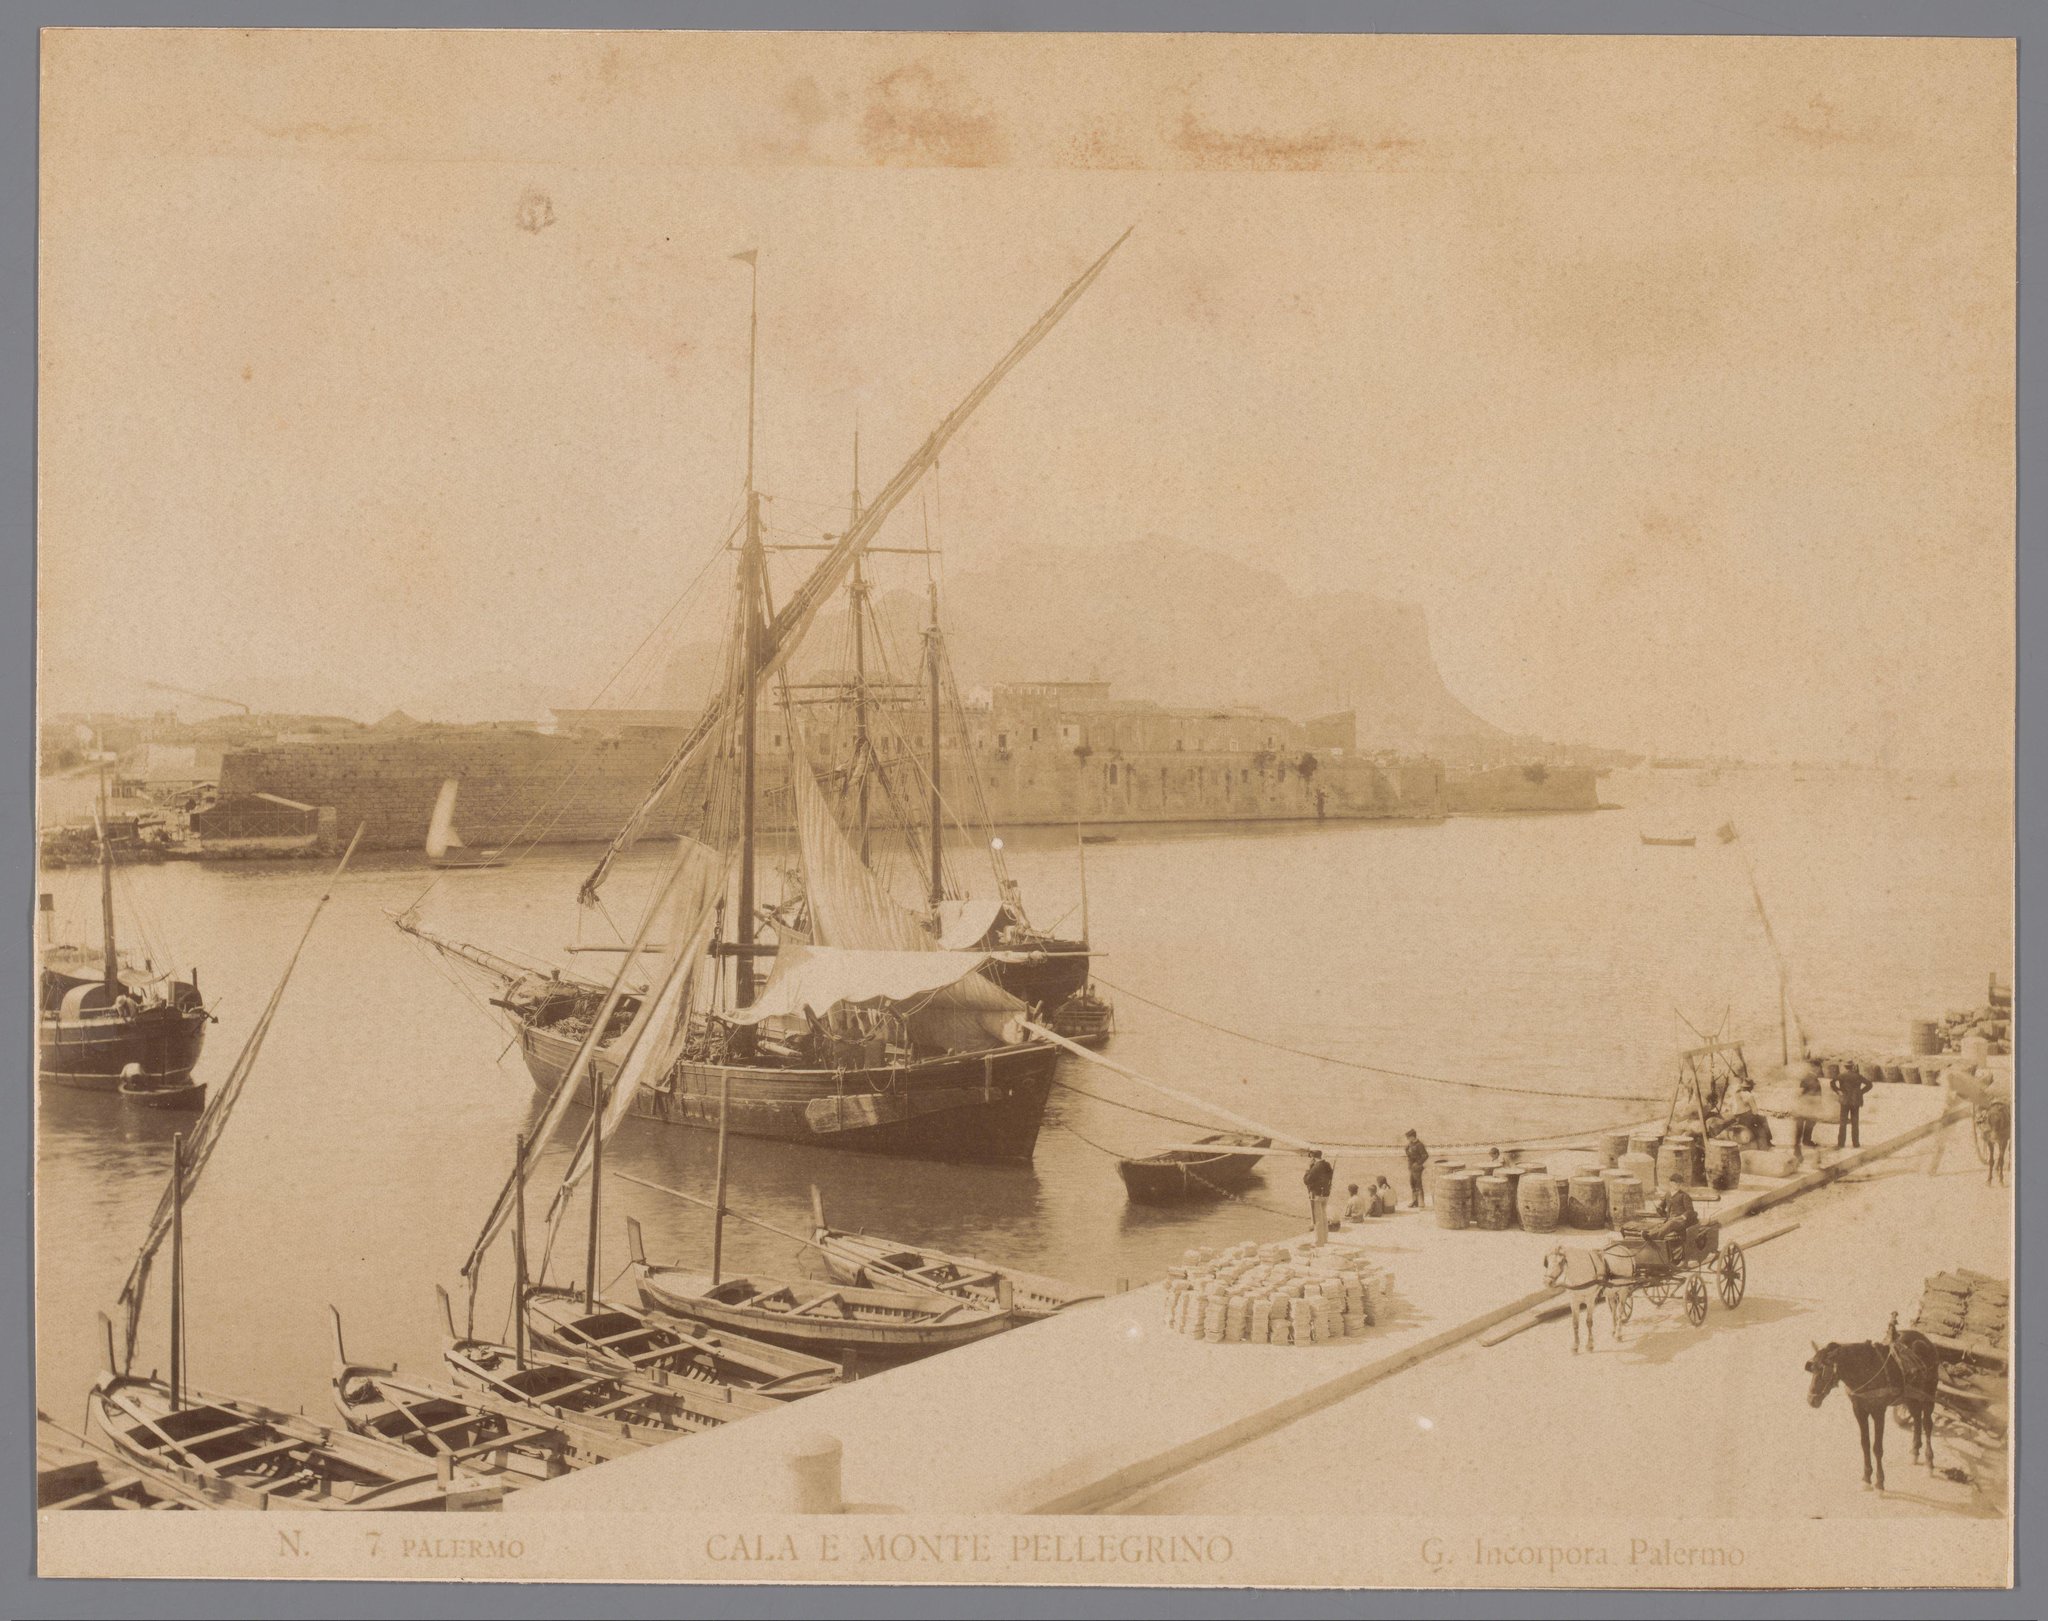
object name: photograph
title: Cala e Monte Pellegrino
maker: giuseppe incorpora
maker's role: fotograaf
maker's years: 1834-1914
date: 1856-1914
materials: paper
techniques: albumen print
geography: palermo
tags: harbour, ships (in general), mountains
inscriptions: number: ‘N. 7’